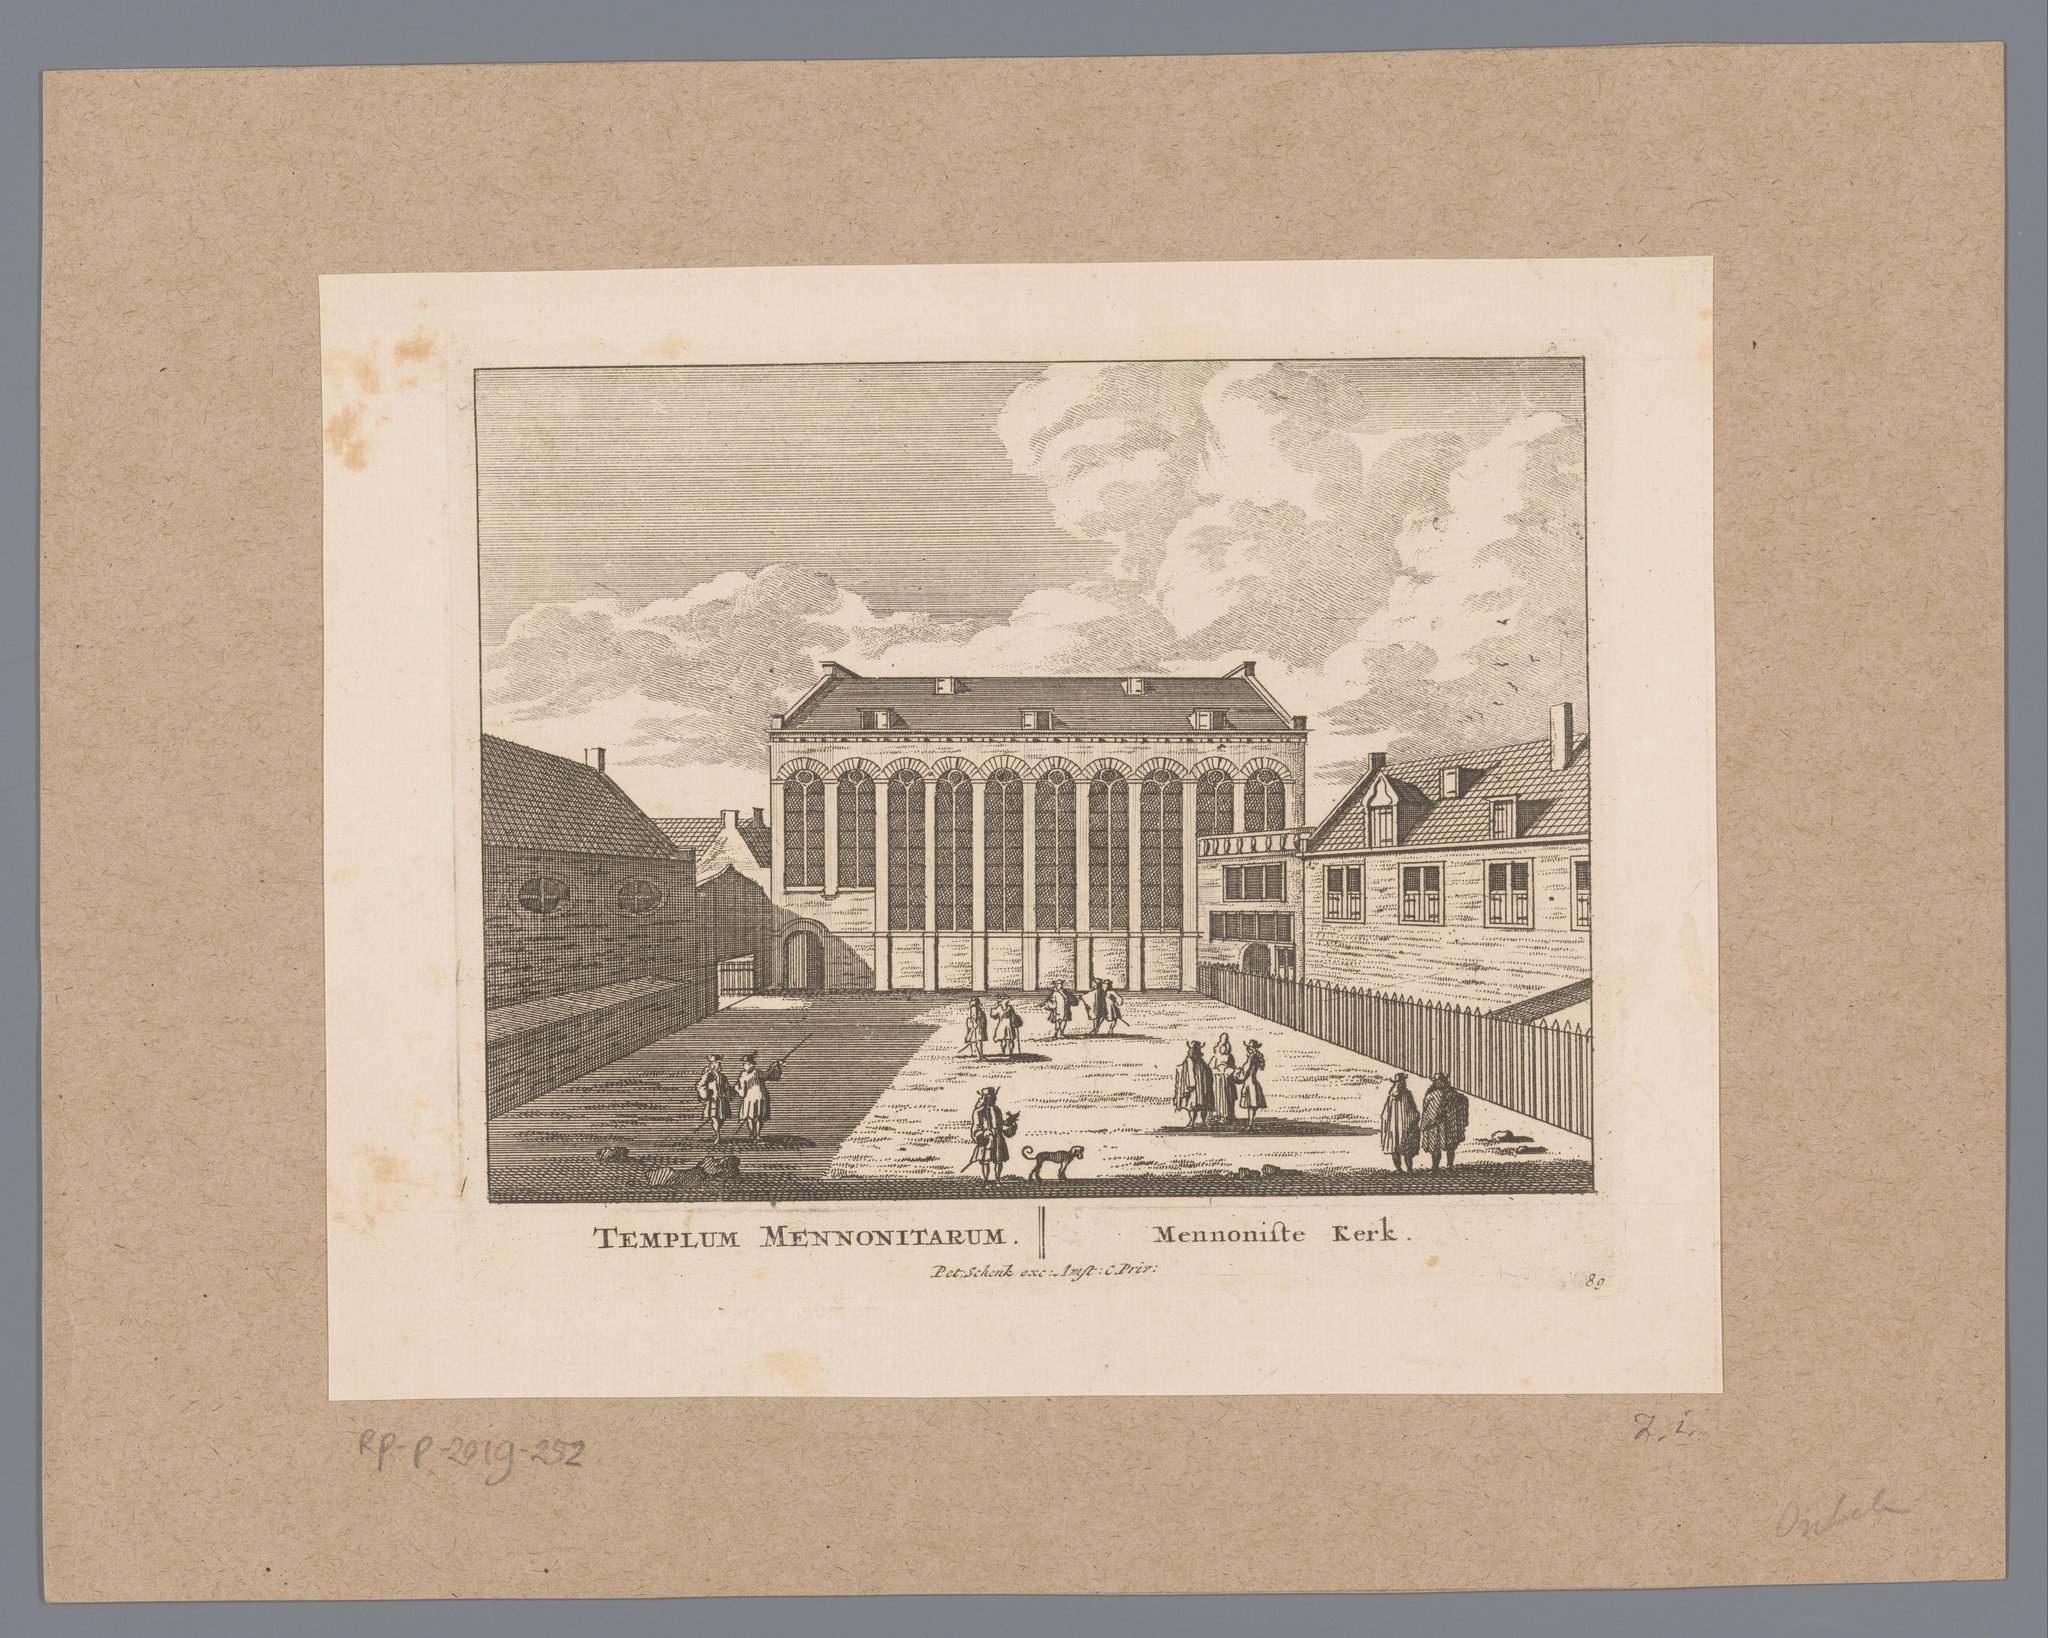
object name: print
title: Gezicht op de Doopsgezinde Kerk Bij 't Lam te Amsterdam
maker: Anonymous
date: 1710-1711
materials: paper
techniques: etching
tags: protestant churches and denominations (mennonites), church (exterior), city-view, and landscape with man-made constructions (+ city(-scape) with figures, staffage)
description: Huidige staat van prent ook gebruikt in: 100 Afbeeldinge der voornaamste gebouwen van Amsterdam. Amsterdam: Pieter Schenk (I), s.a. [1710-1711]. En in: 100 Afbeeldinge der voornaamste gebouwen van Amsterdam. Amsterdam: Barent Greve, s.a. [1757-1766].* *In de tweede uitgave, uitgegeven door Barent Greve, is alleen de titelprent aangepast. De overige prenten zijn onveranderd gebleven.